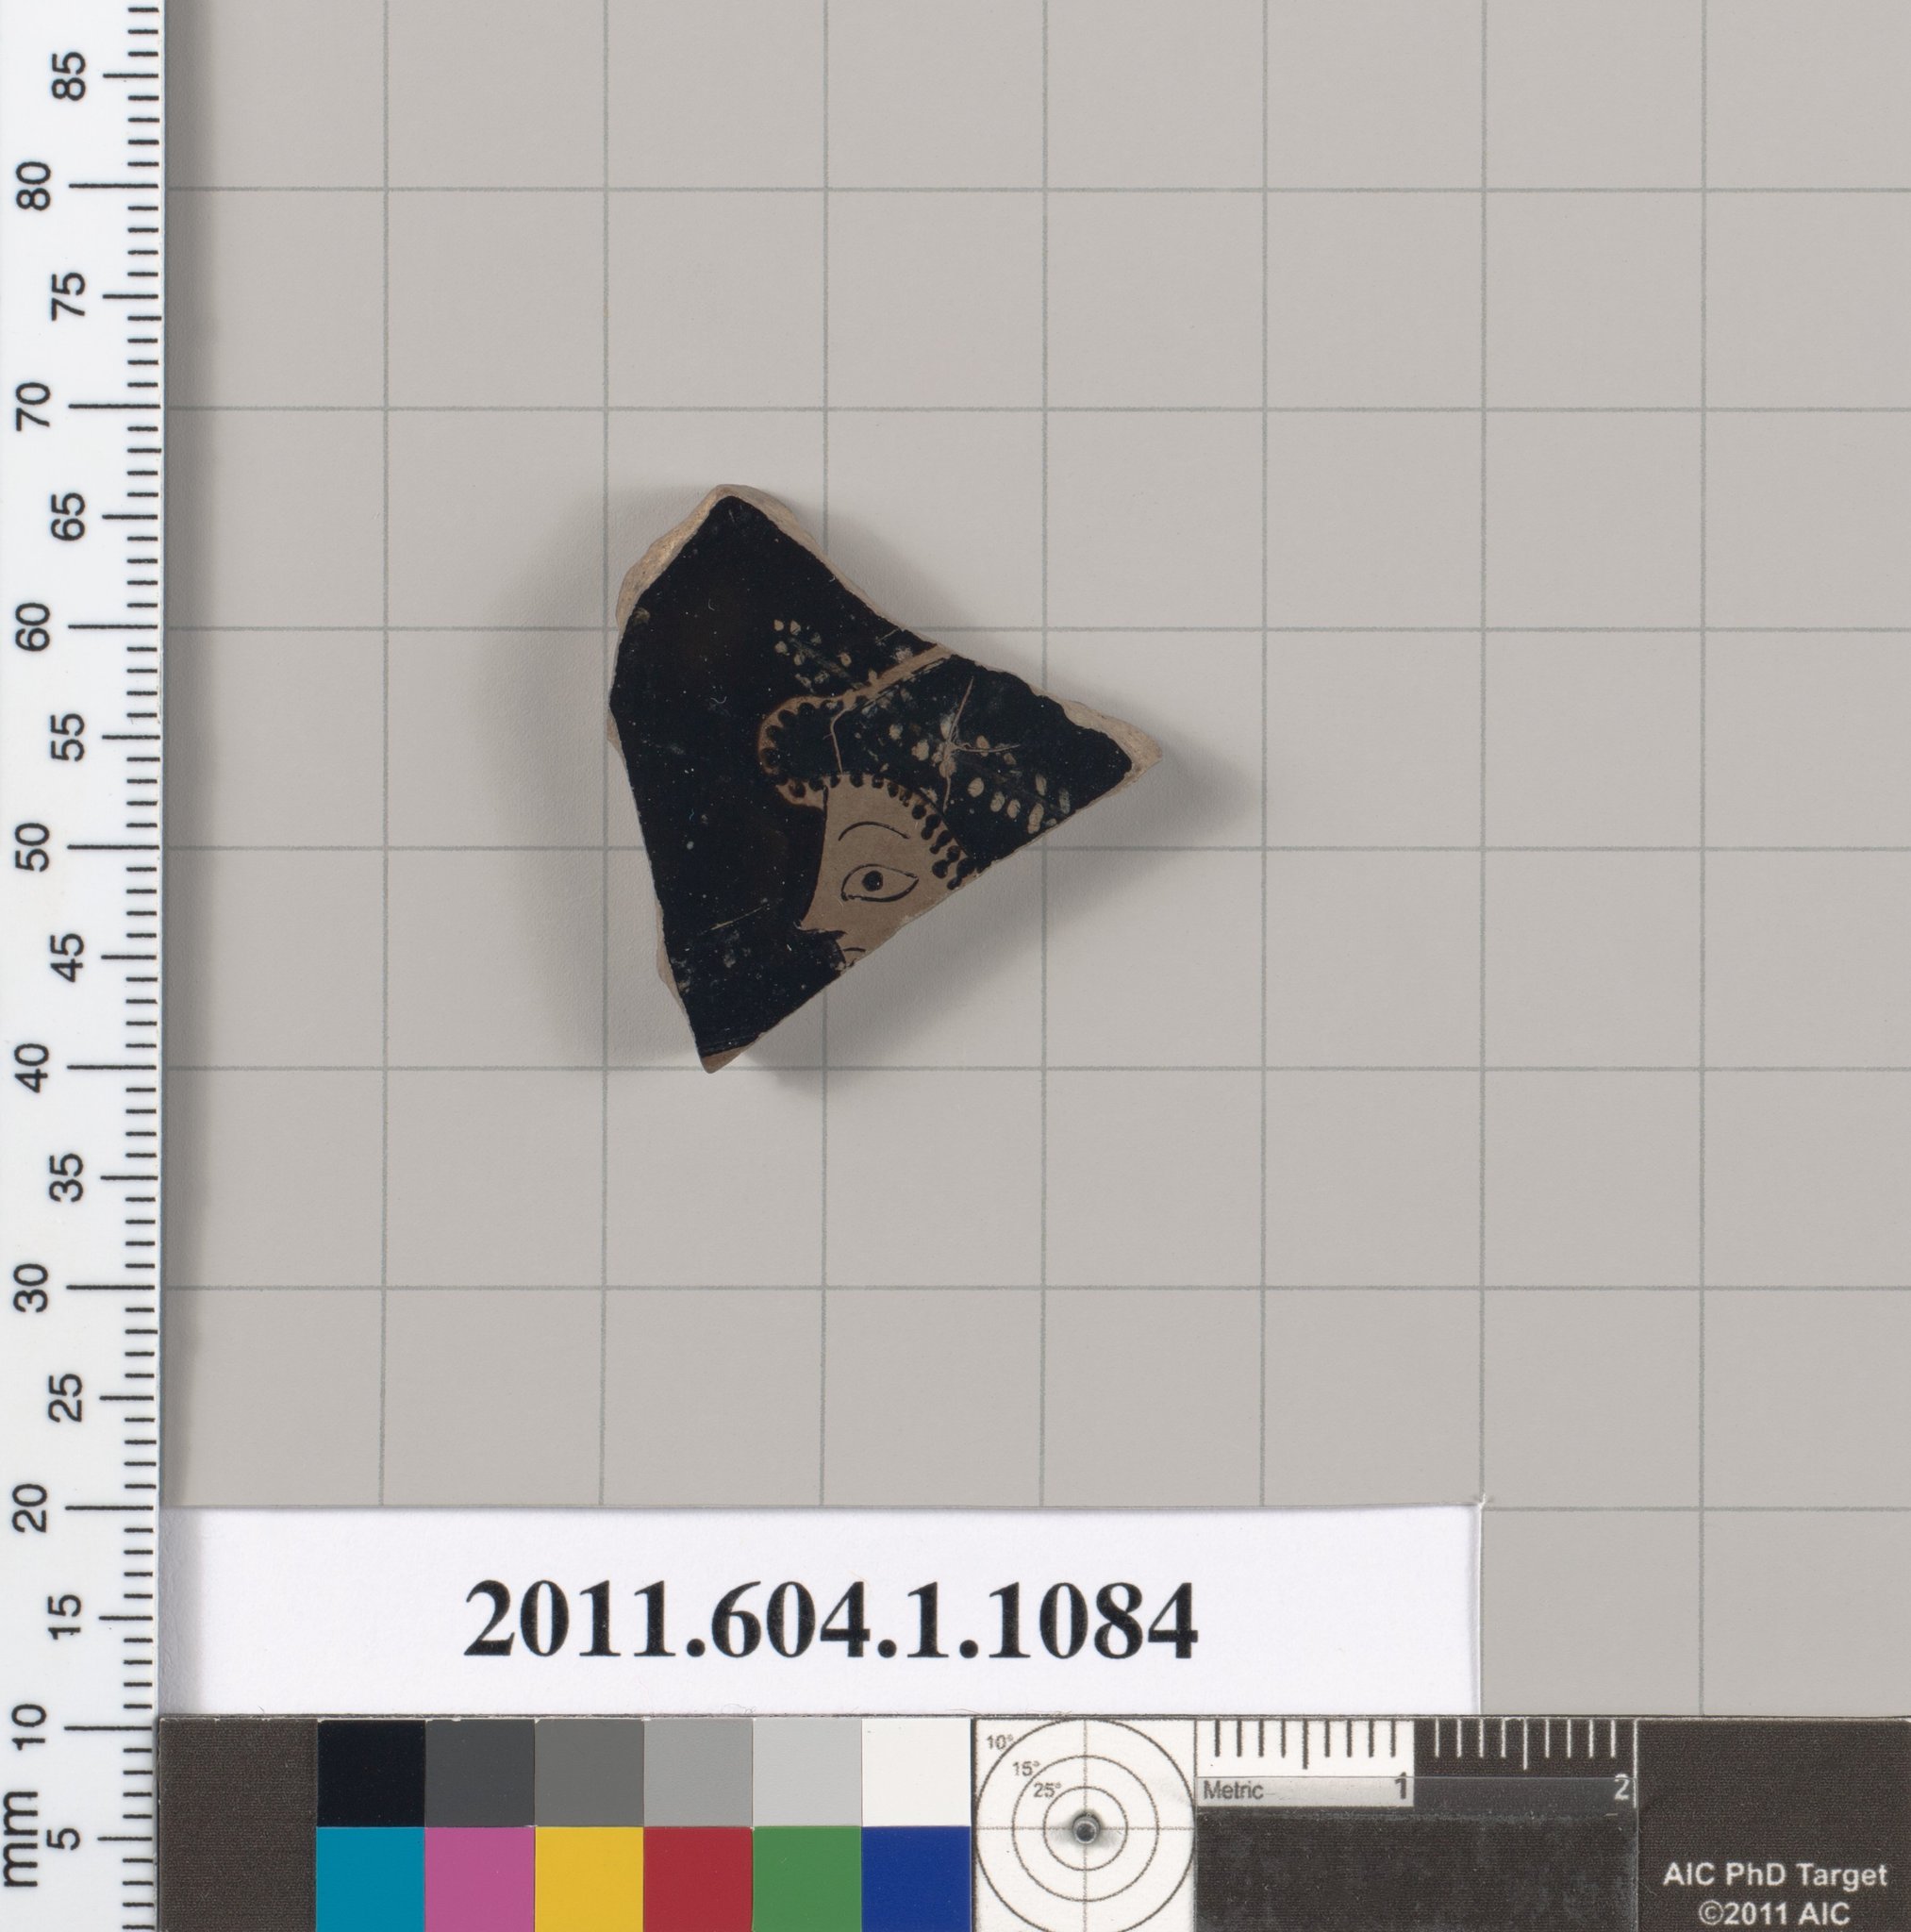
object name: kylix fragment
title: Terracotta fragment of a kylix (drinking cup)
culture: greek, attic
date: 510-500 BCE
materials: terracotta